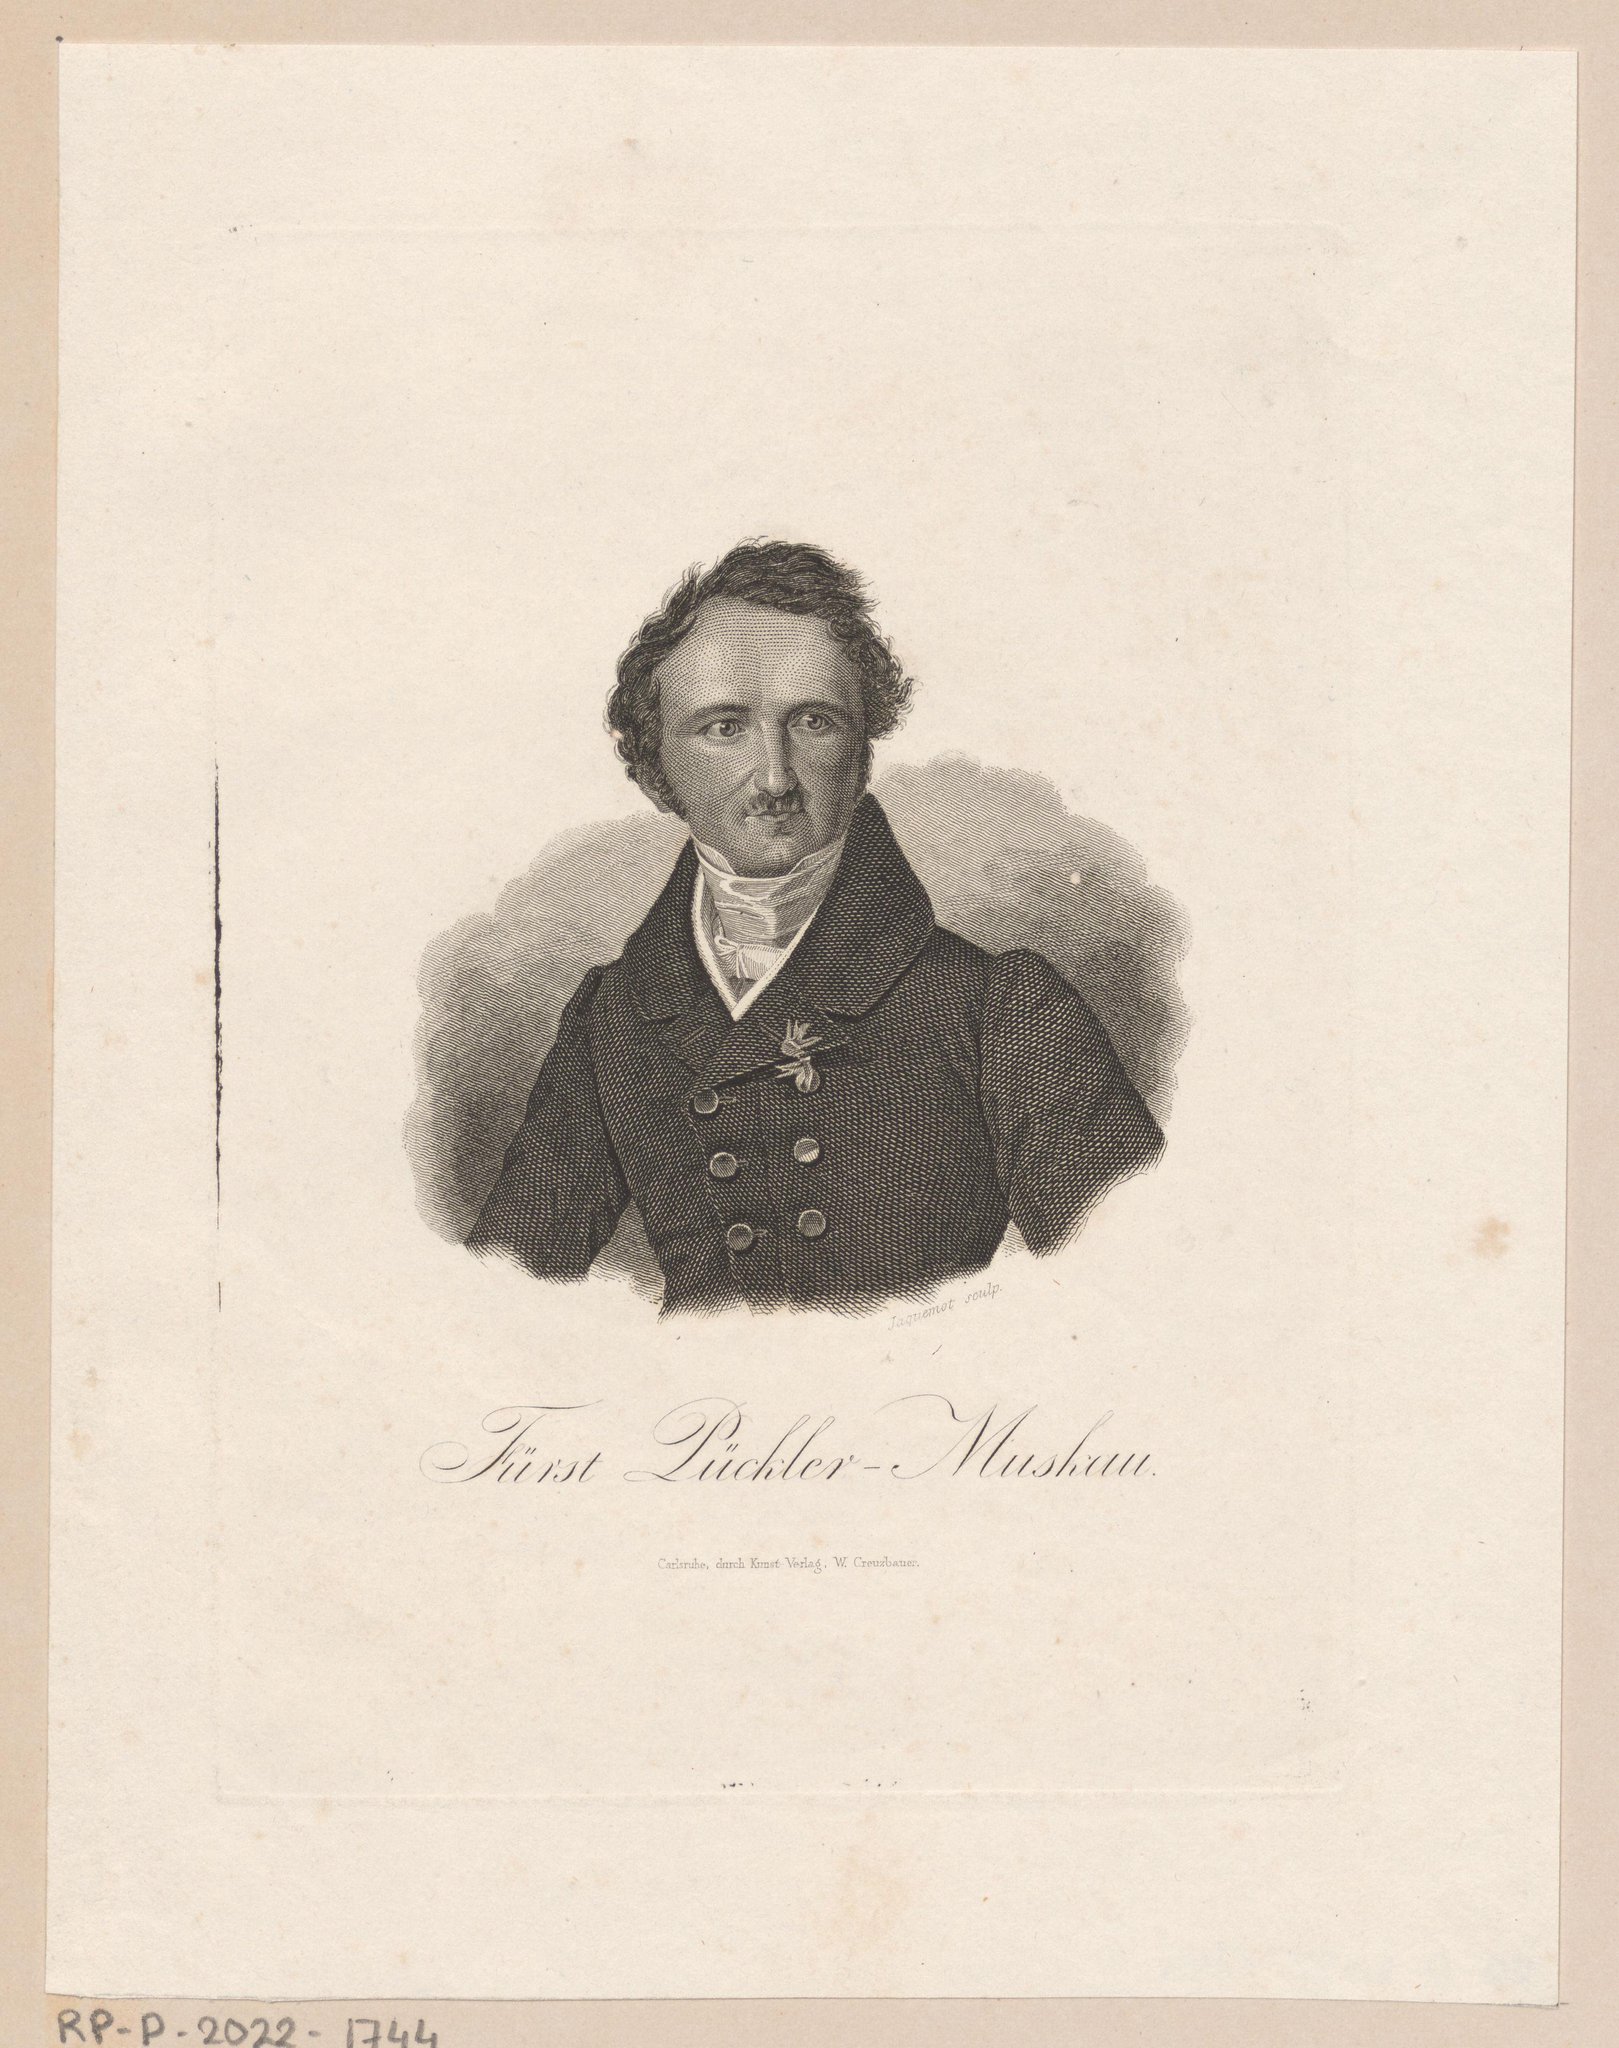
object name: print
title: Fürst Pückler-Muskau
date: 1822-1880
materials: paper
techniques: engraving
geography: karlsruhe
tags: ranks in the army, historical persons, portrait of a writer